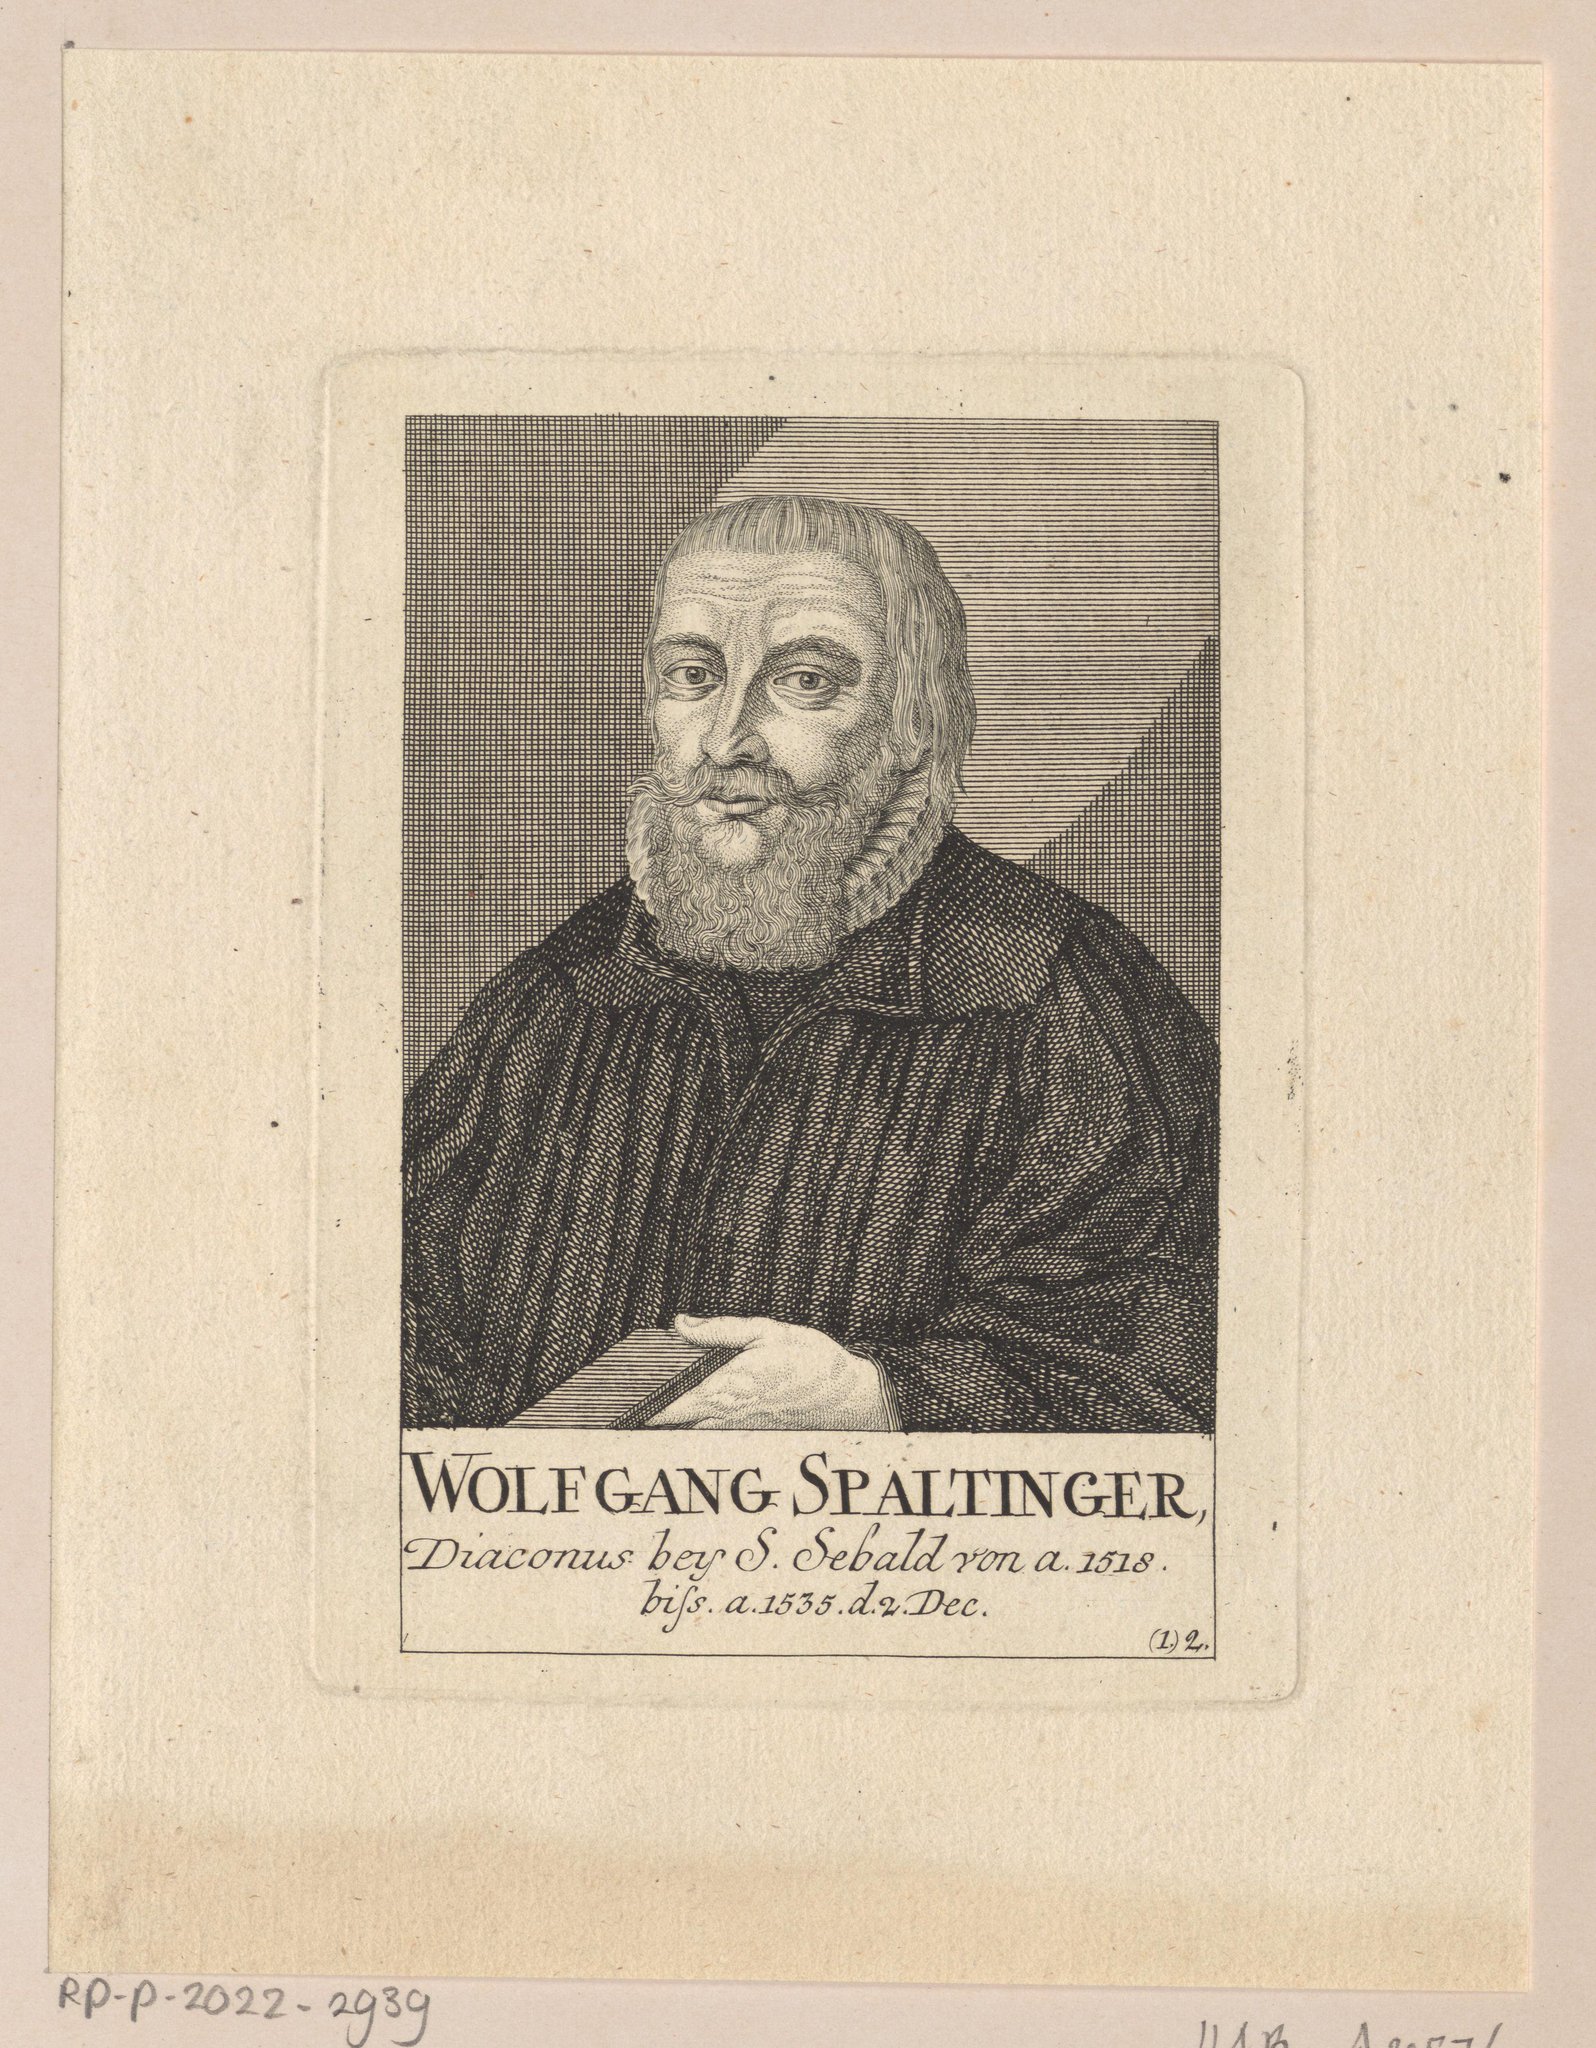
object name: print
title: Portret van Wolfgang Spaltinger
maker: christoph melchior roth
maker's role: print maker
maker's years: 1720-1798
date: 1756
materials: paper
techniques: engraving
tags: functionaries and dignitaries (with name) ~ episcopal protestant churches, historical persons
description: Prent uit: Würfel, Andreas. Diptycha ecclesiae Sebaldianae (...). Neurenberg: Christoph Melchior Roth, 1756.